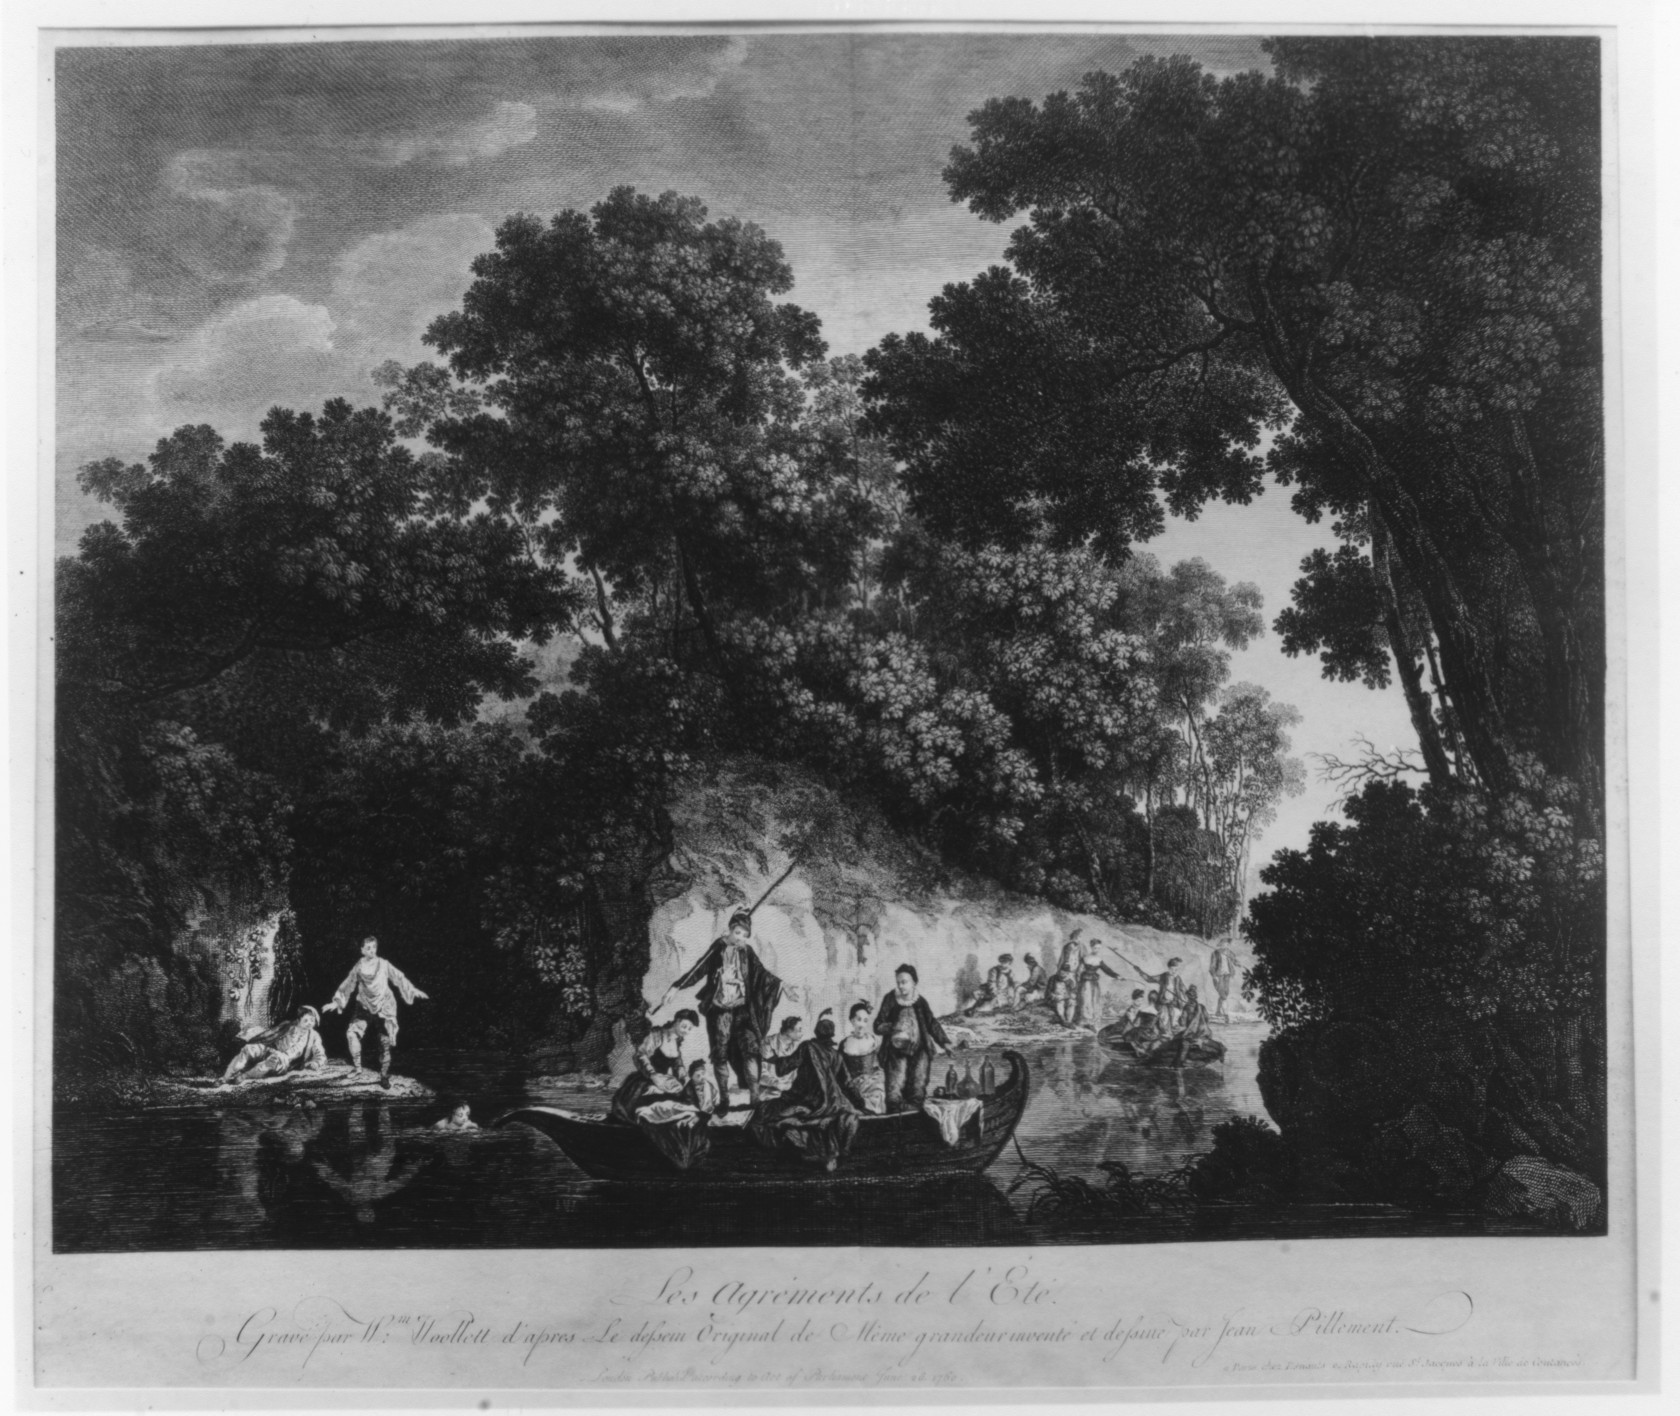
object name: print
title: The Pleasures of Summer (Les Agréments de Été)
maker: pierre charles canot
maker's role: engraver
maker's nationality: french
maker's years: 1710-1777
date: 1759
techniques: etching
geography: france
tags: men,women,trees,boats